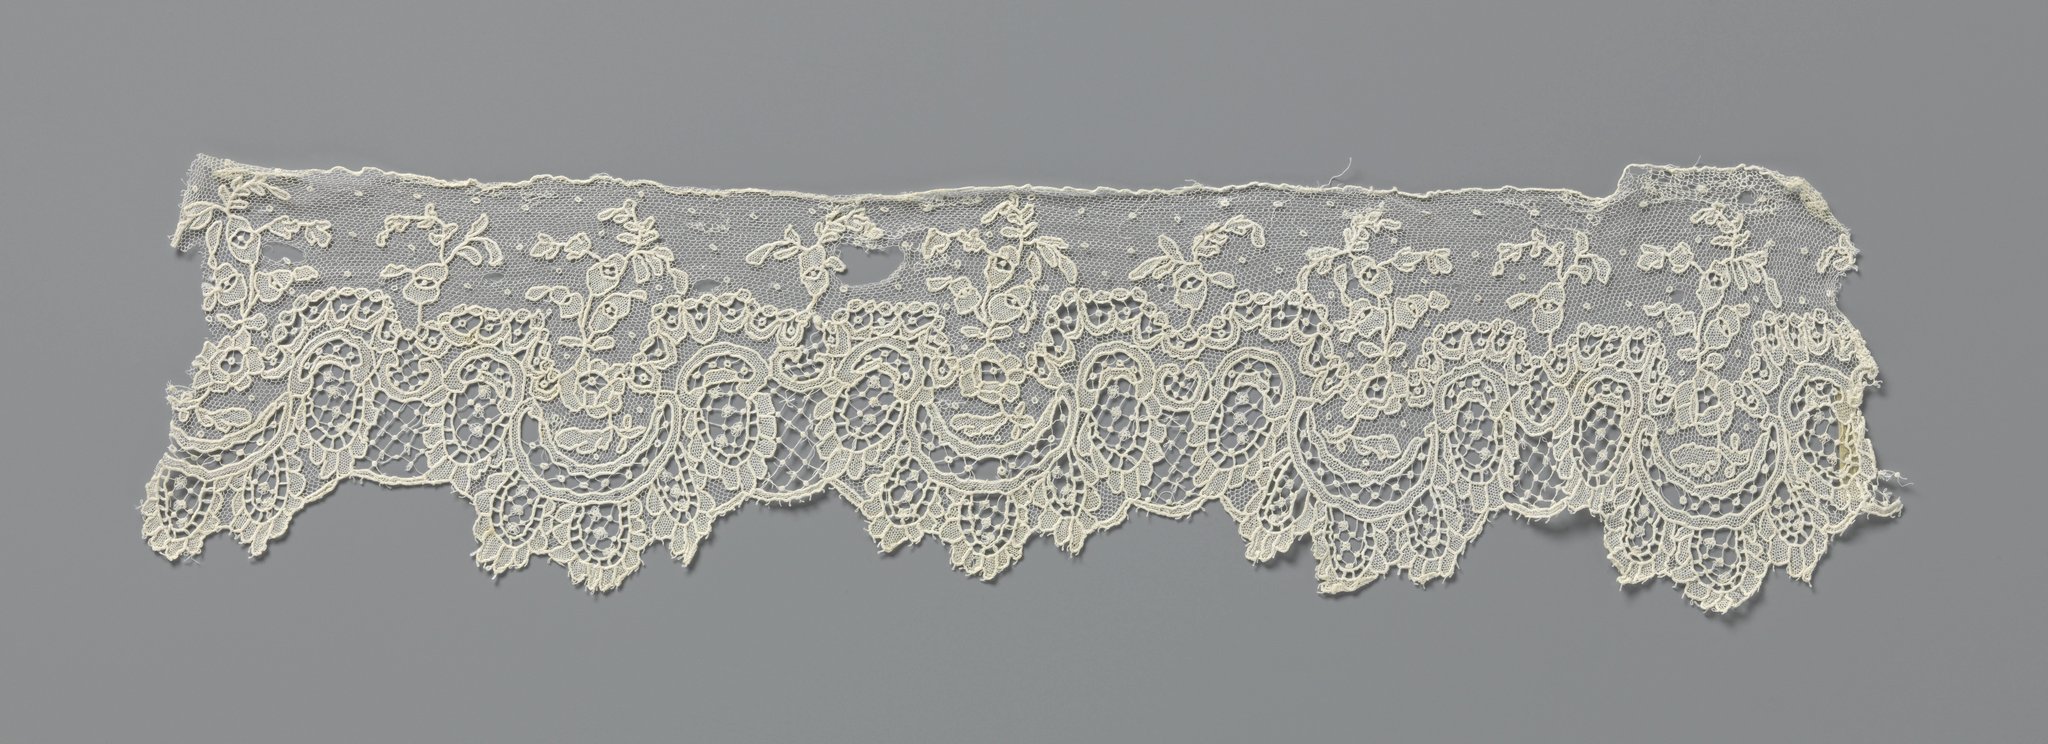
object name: strip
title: Strook naaldkant met liggende c-voluut met vijf lobben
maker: Anonymous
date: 1850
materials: linen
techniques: needle lace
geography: brussels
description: Strook naturelkleurig naaldkant, point de gaze de Bruxelles. Repetitief motief van een liggende c-voluut met vijf lobben op een fijne grond met enkelvoudige gedraaide mazen, die met moesjes is bezaaid. In de holte van het voluut steeds een roosje waaruit een bloemtakje omhoog steekt. Over de middellijn van de strook slingert een aaneenschakeling van bloemen langs het patroon met de lobben. Veel verschillende siergronden vullen de lobben, bloembladen en tussenruimtes. De schulpen langs de onderzijde worden gevormd door het patroon met lobben. De bovenzijde is afgewerkt met een rechte rand.